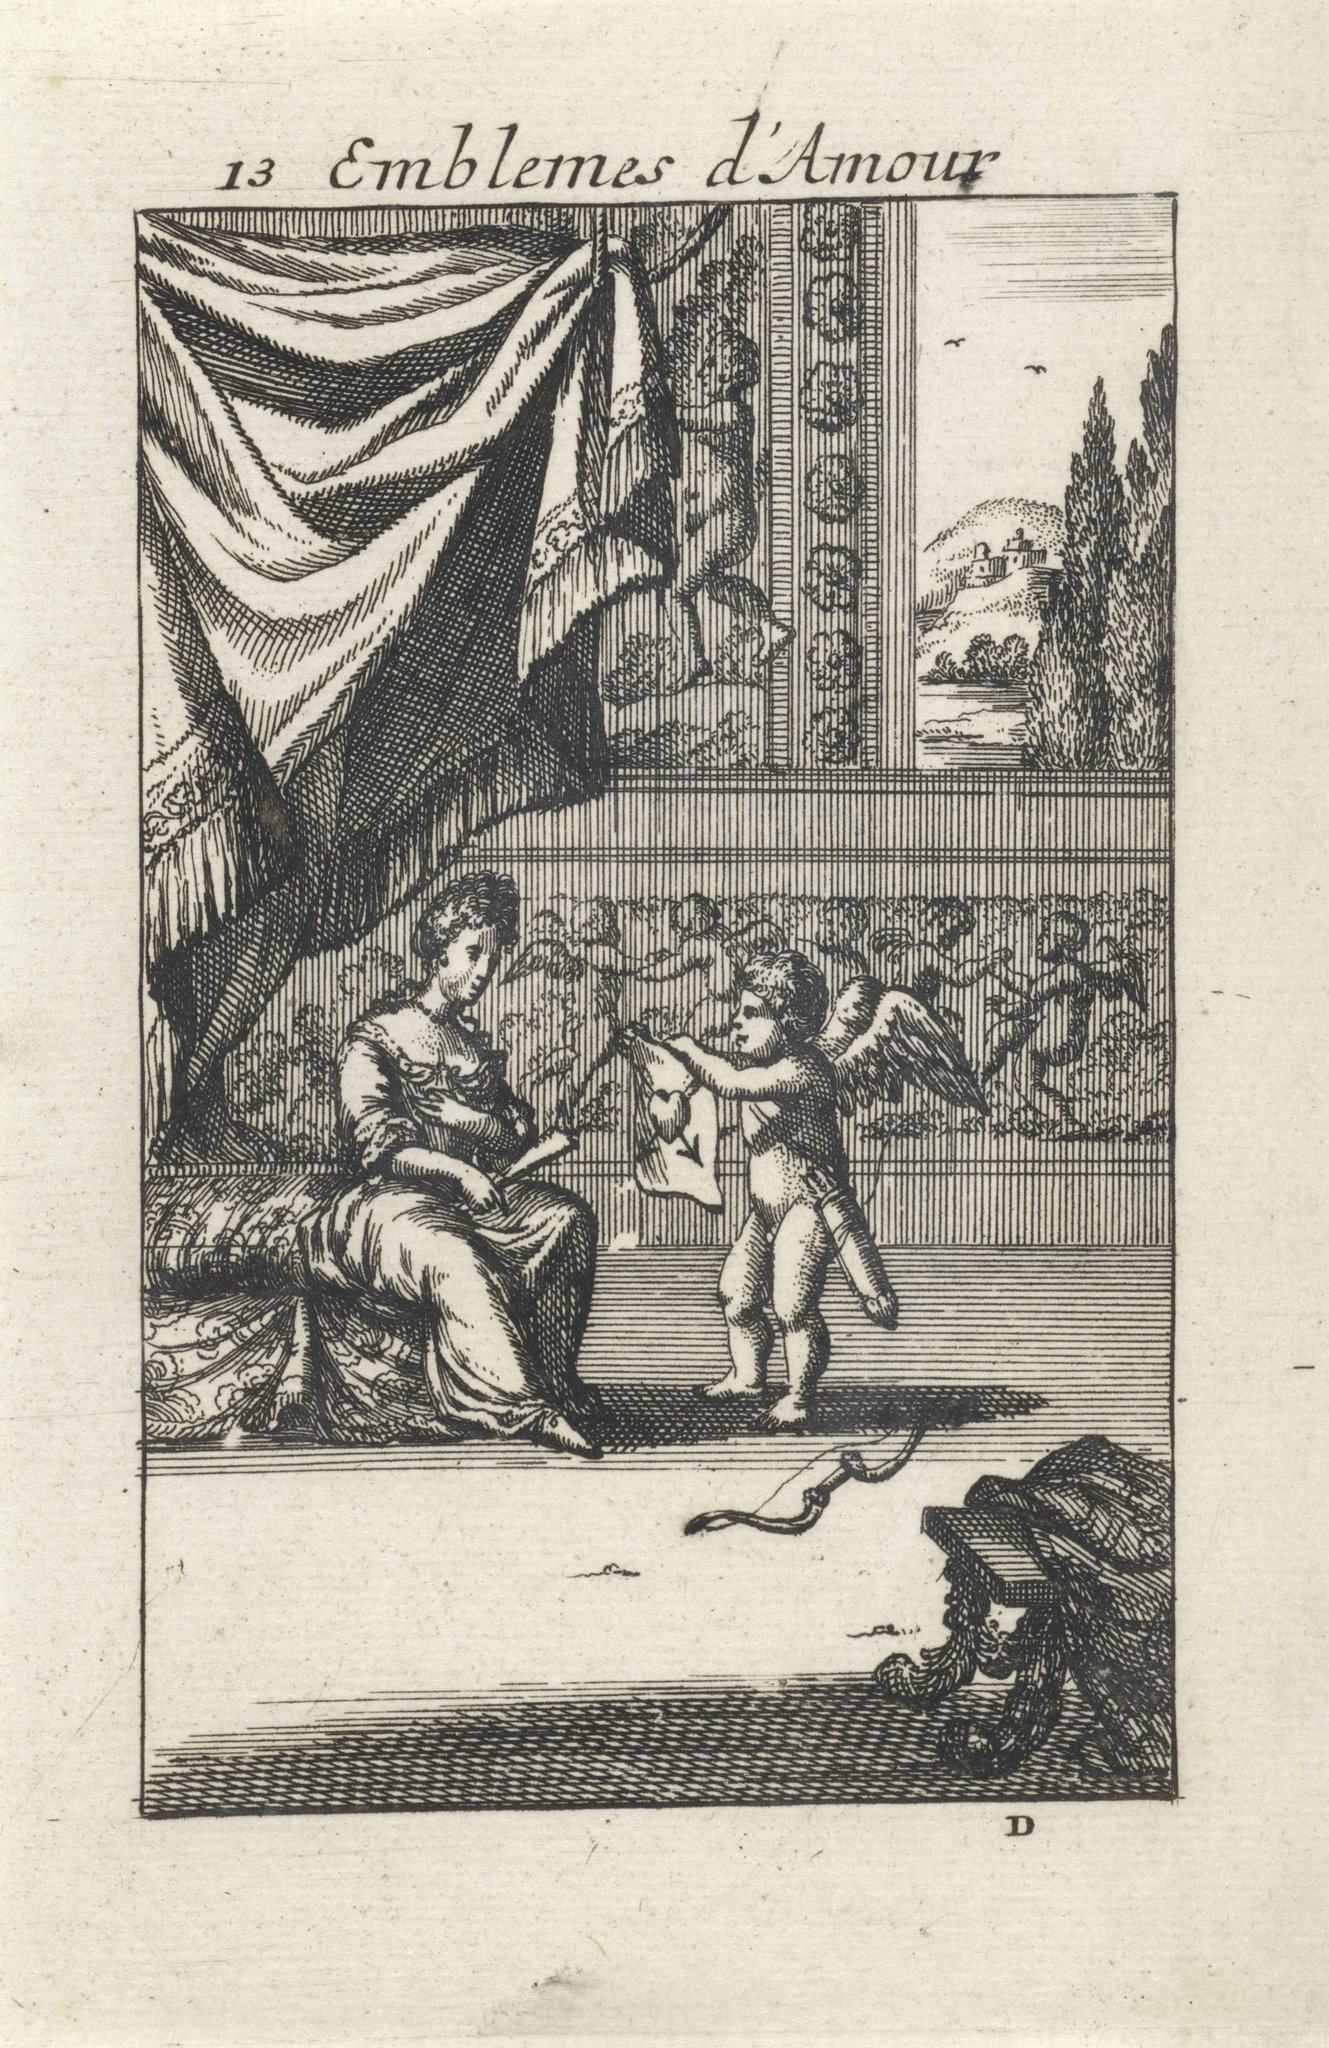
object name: book illustration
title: Amor houdt een afbeelding van een hart op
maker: jan van vianen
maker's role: print maker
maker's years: 1660-1726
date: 1686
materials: paper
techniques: etching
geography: northern netherlands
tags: canopy, baldachin, (story of) cupid, amor (eros), profane heart symbolism ~ love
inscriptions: collector's mark: Lugt 2228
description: Amor toont een vrouw onder een baldakijn een afbeelding van een met pijlen doorboord hart. De liefde behoeft geen woorden, maar daden. Dertiende embleem uit Emblemata Amatoria.